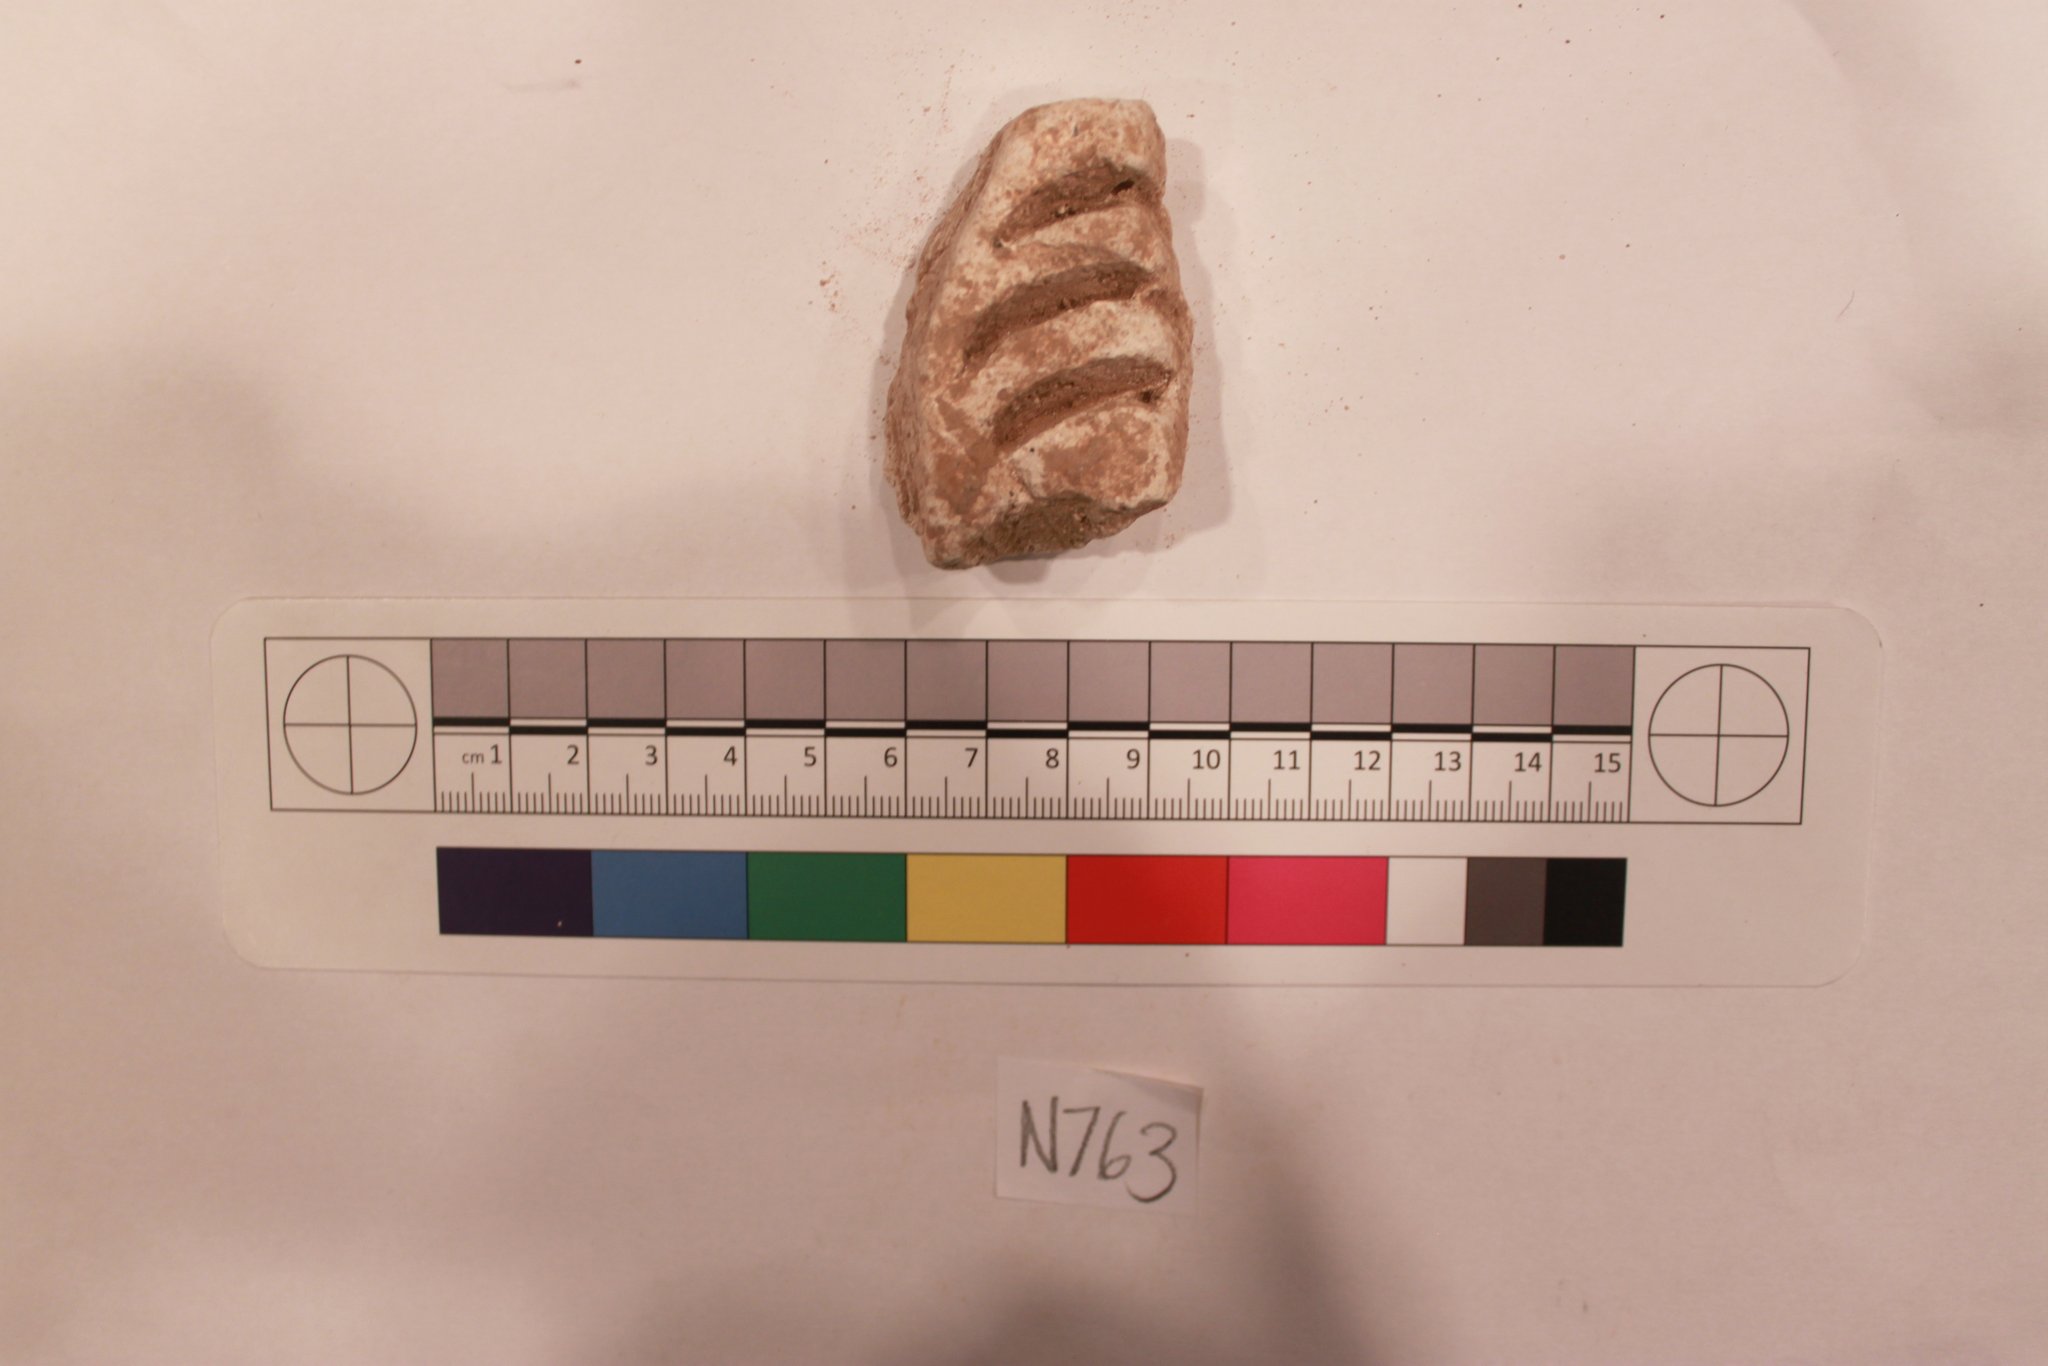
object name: fragment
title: Stucco Fragment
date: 701-1200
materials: plaster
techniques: carving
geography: iran